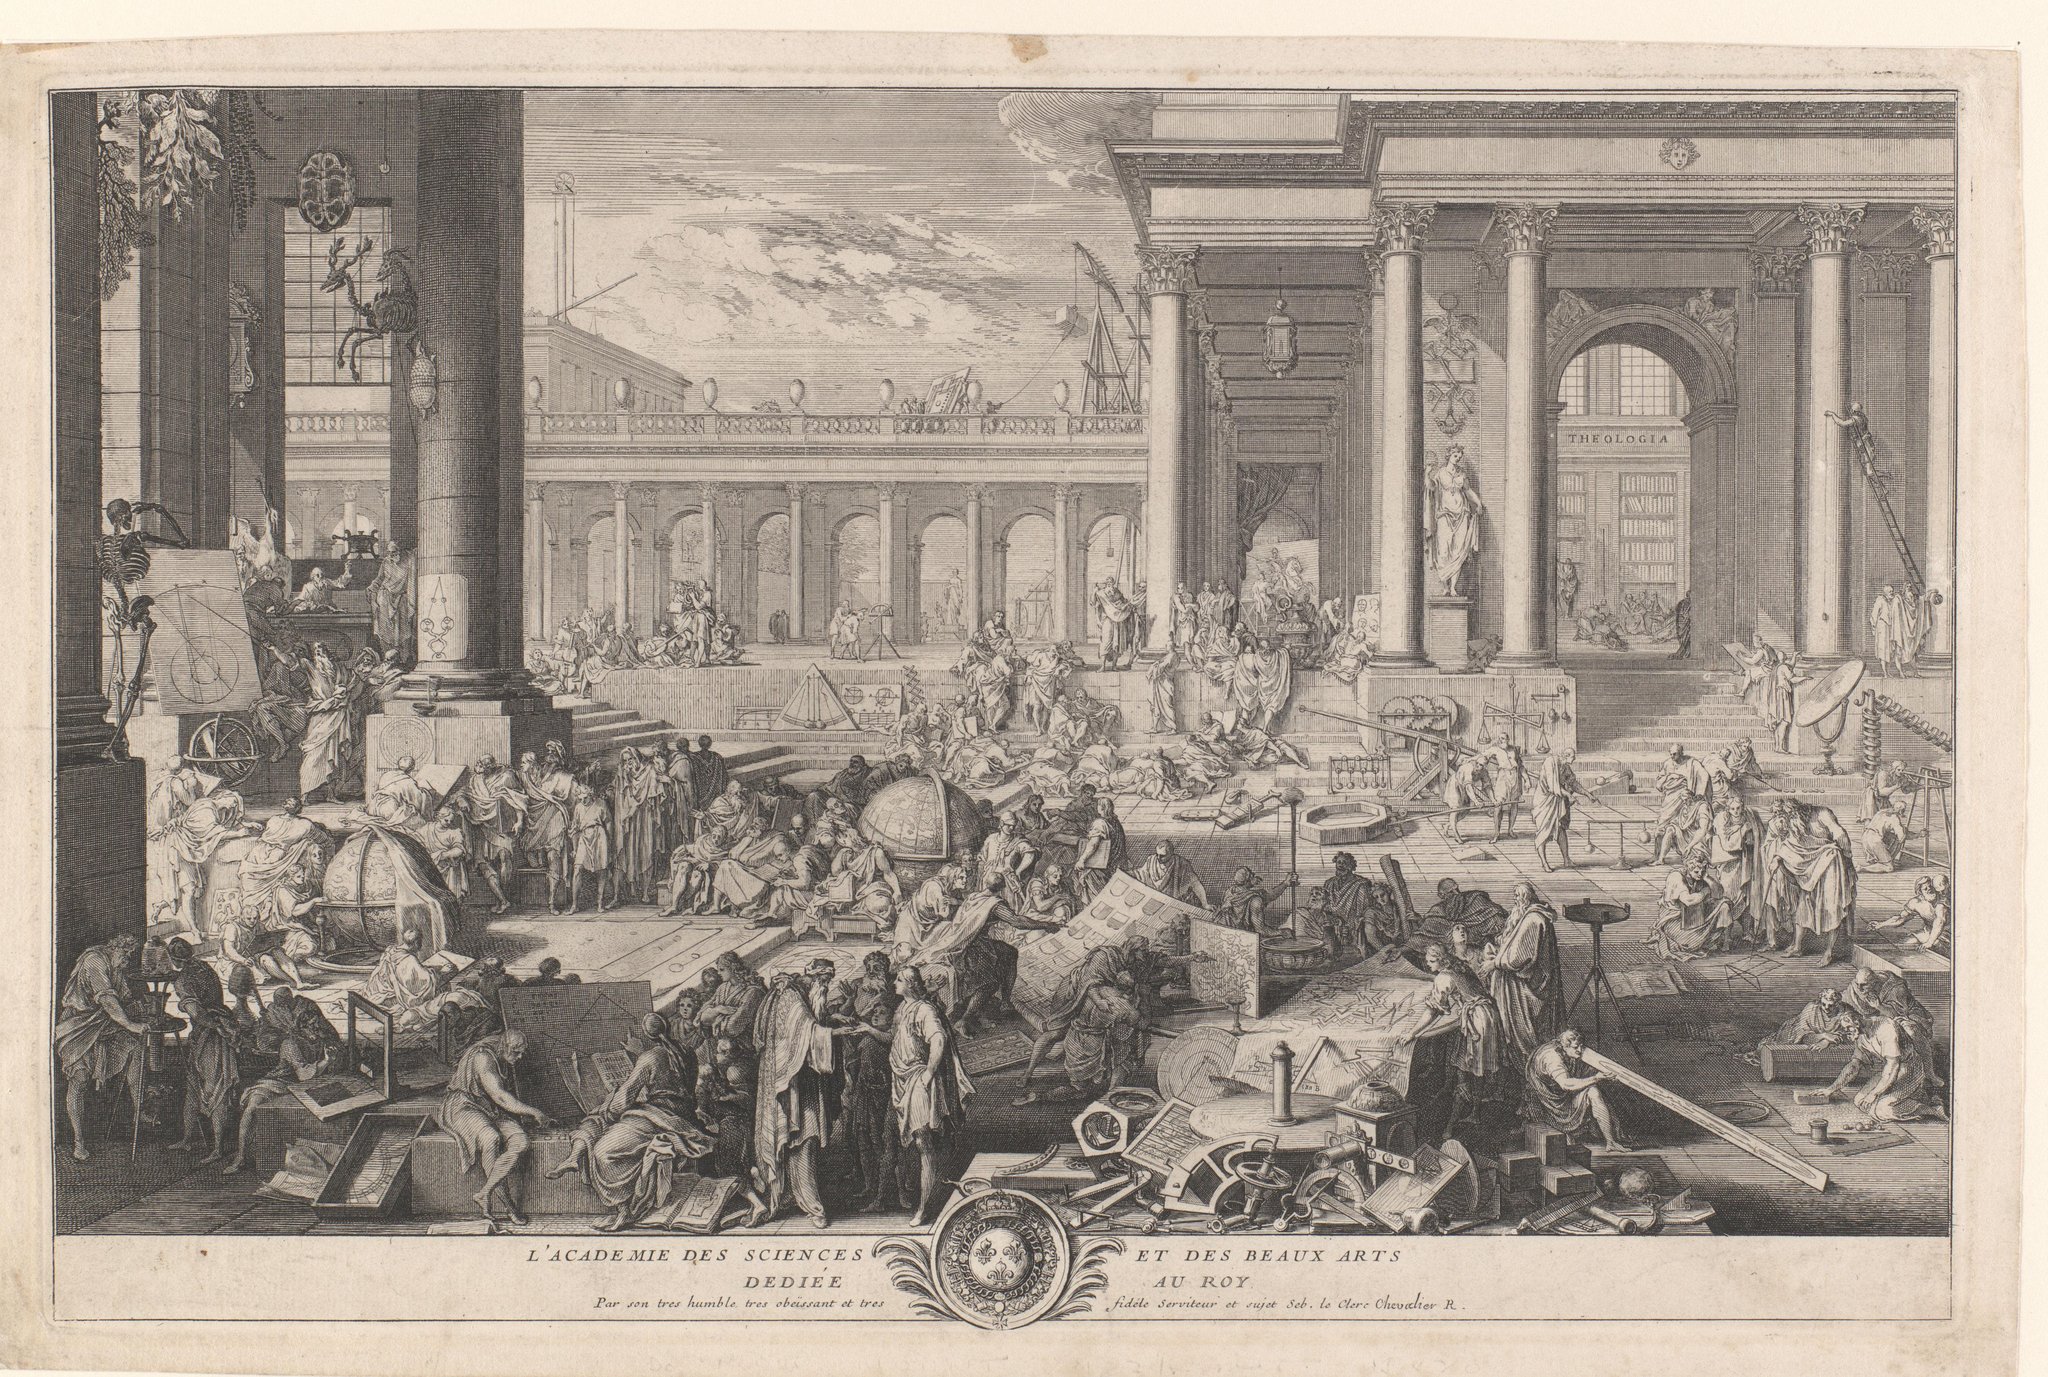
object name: print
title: Verschillende disciplines in de Académie des sciences et des beaux arts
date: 1698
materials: paper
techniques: engraving, etching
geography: france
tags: academy, association of artists, place or institution of education and training of the artist, e.g.: academy of art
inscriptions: collector's mark: Lugt 2228, collector's mark: Lugt 2760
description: Allegorie op de Academie van kunsten en wetenschappen met beoefenaren van tal van disciplines, waaronder de schilderkunst, beeldhouwkunst, architectuur, vestingbouw en wiskunde.